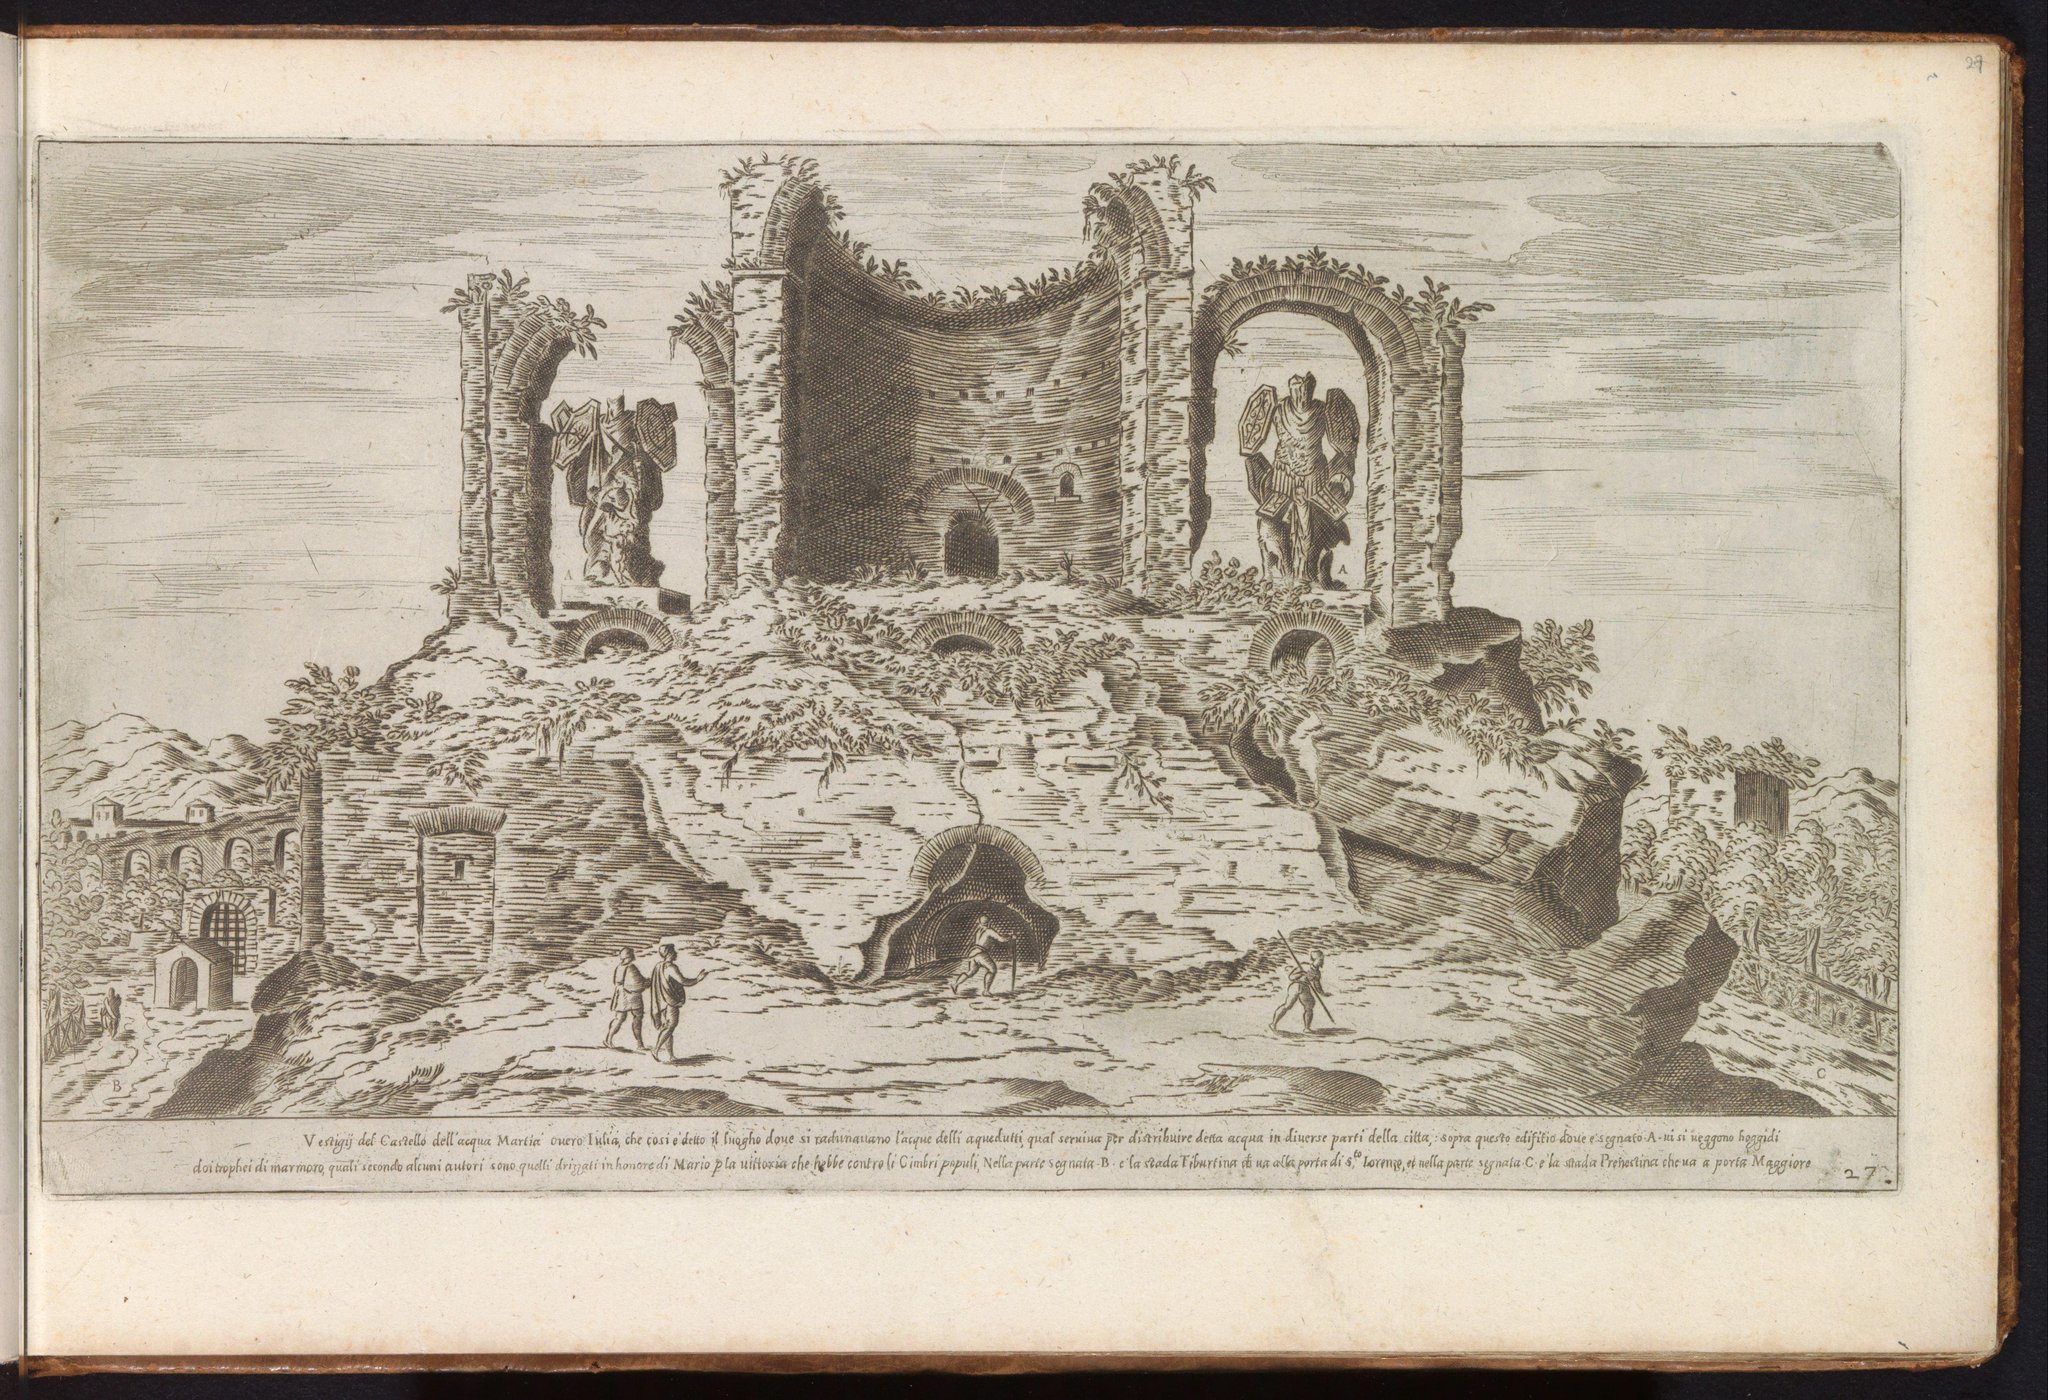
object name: print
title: Ruïnes van de Trofeeën van Marius te Rome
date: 1575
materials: paper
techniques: engraving, etching, intaglio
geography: italy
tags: city-view, and landscape with man-made constructions, ruin of a building ~ architecture, landscape with ruins, rome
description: Gezicht op de resten van de Trofeeën van Marius, een nymphaeum op het huidige Piazza Vittotio Emanuele te Rome. Onderschrift in het Italiaans. Prent maakt deel uit van een album.